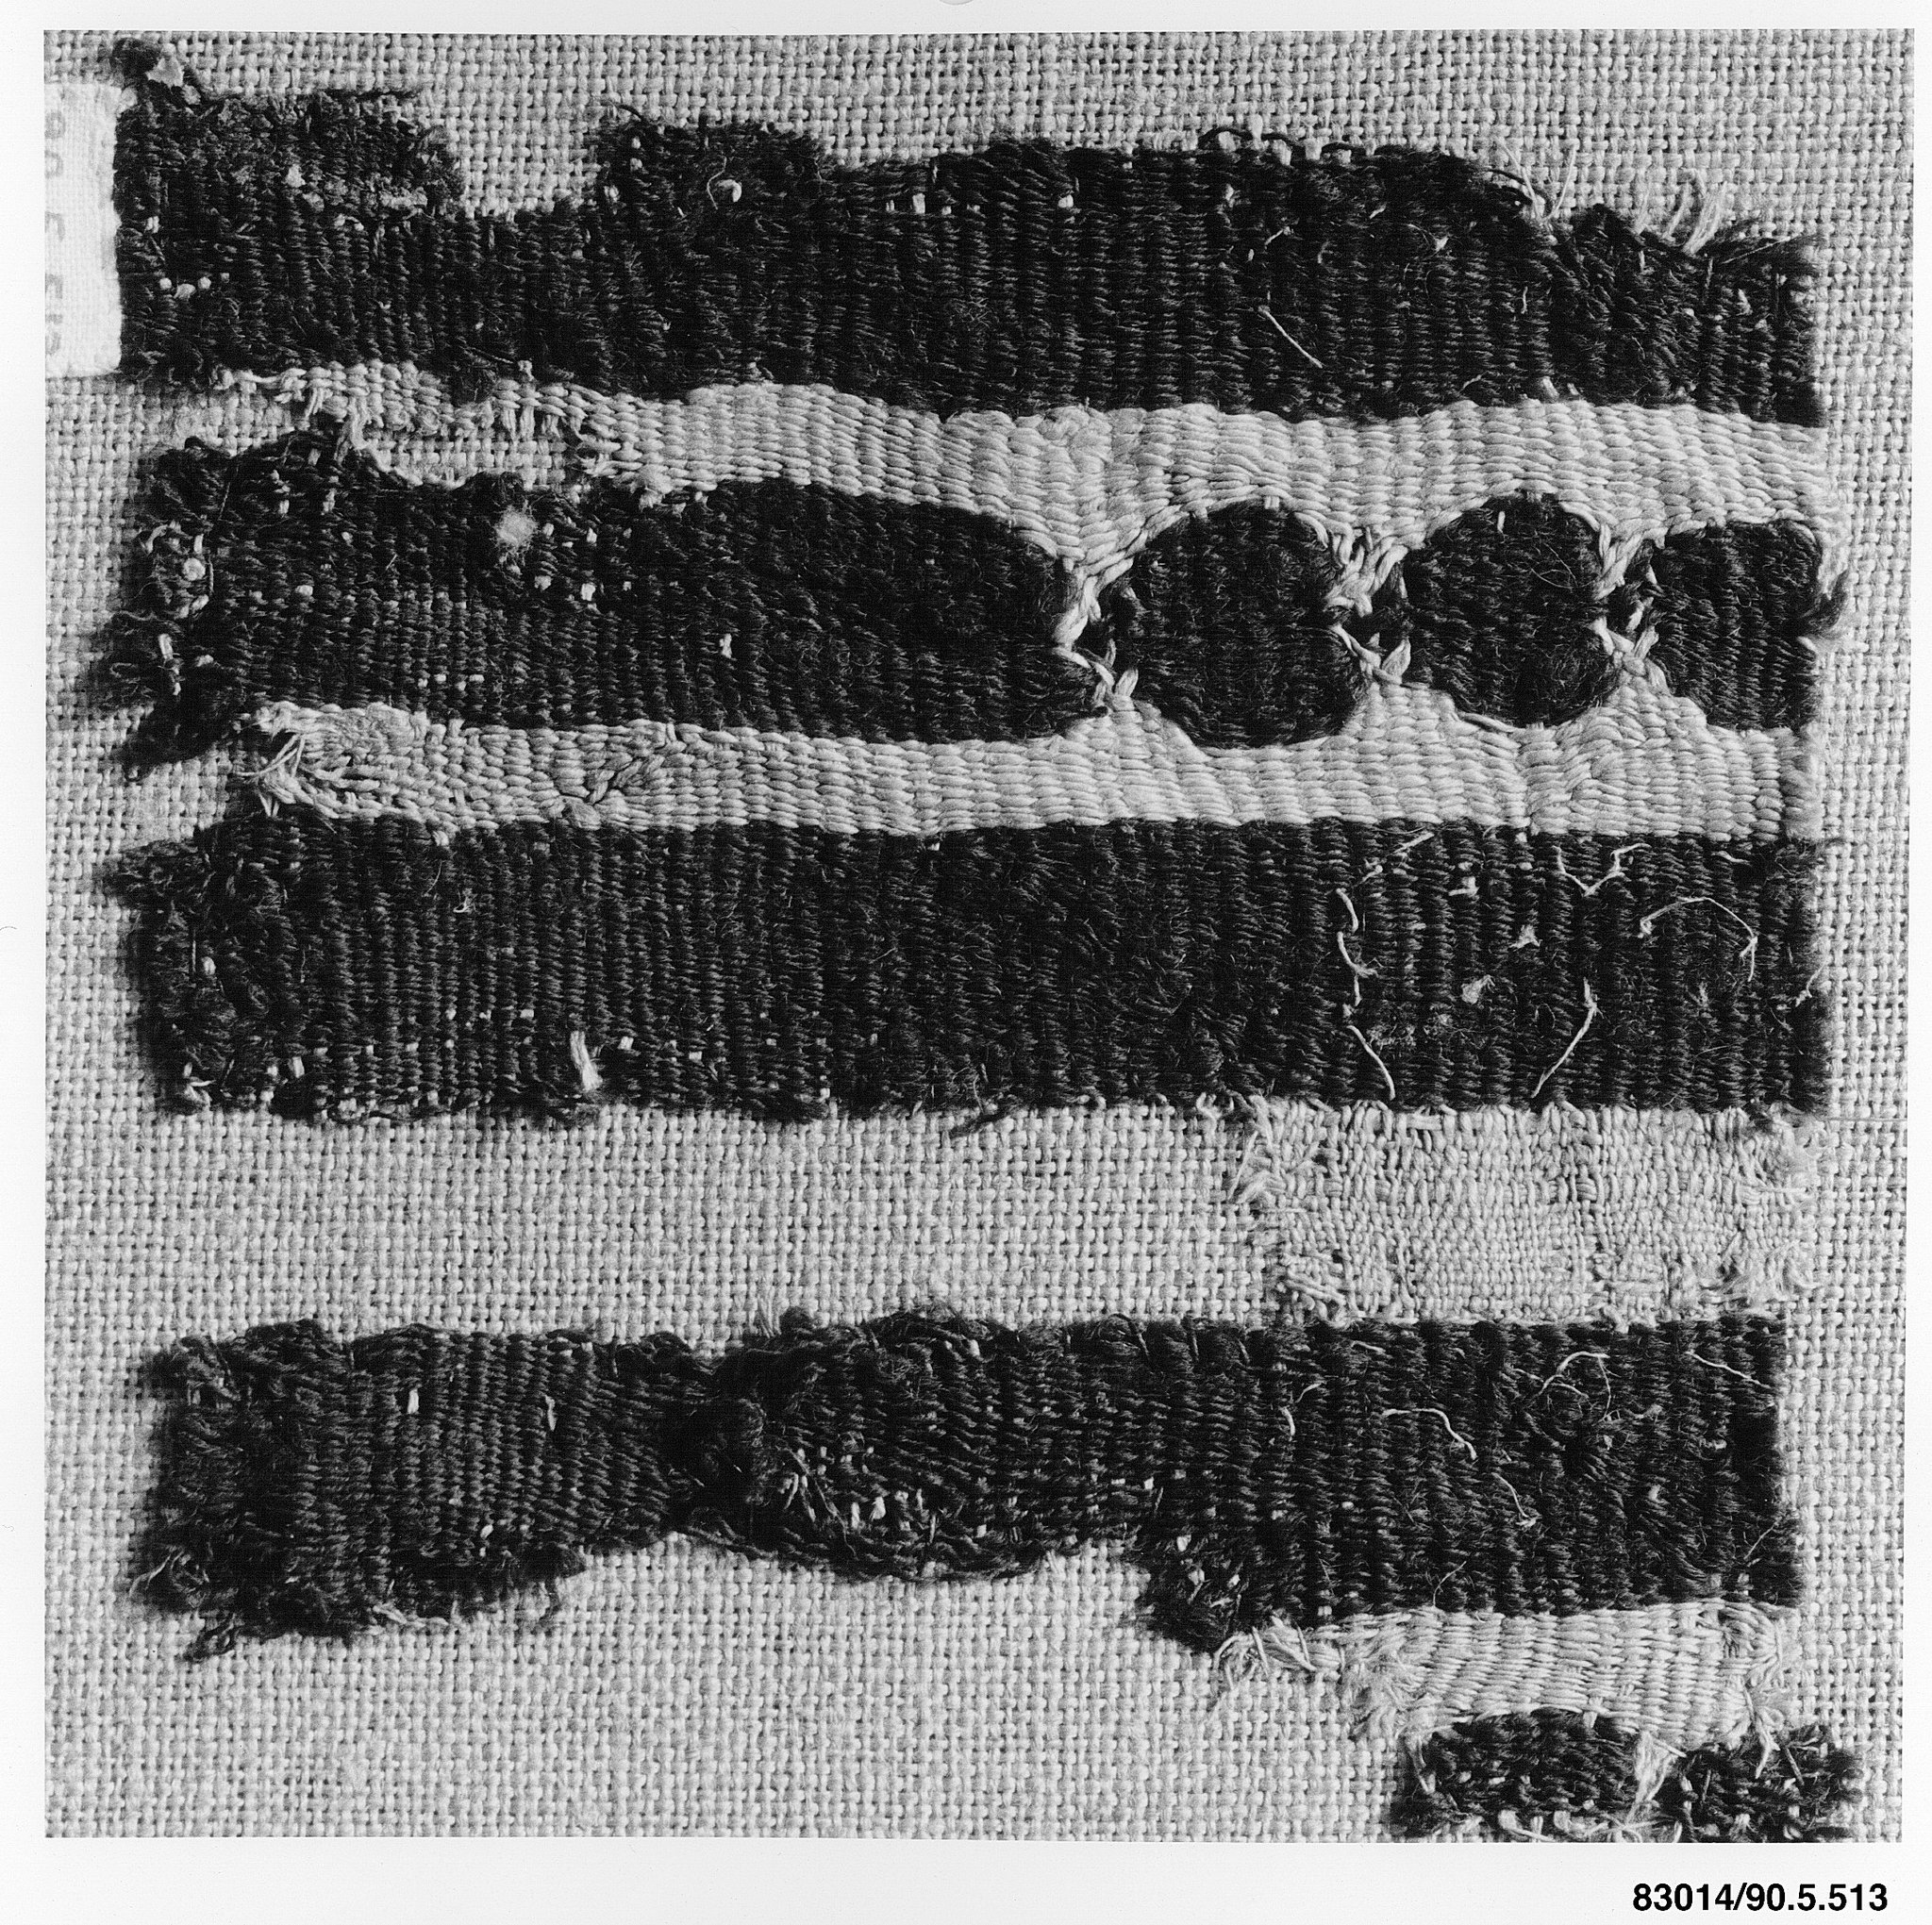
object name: textile fragment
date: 201-400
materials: linen, wool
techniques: weave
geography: egypt